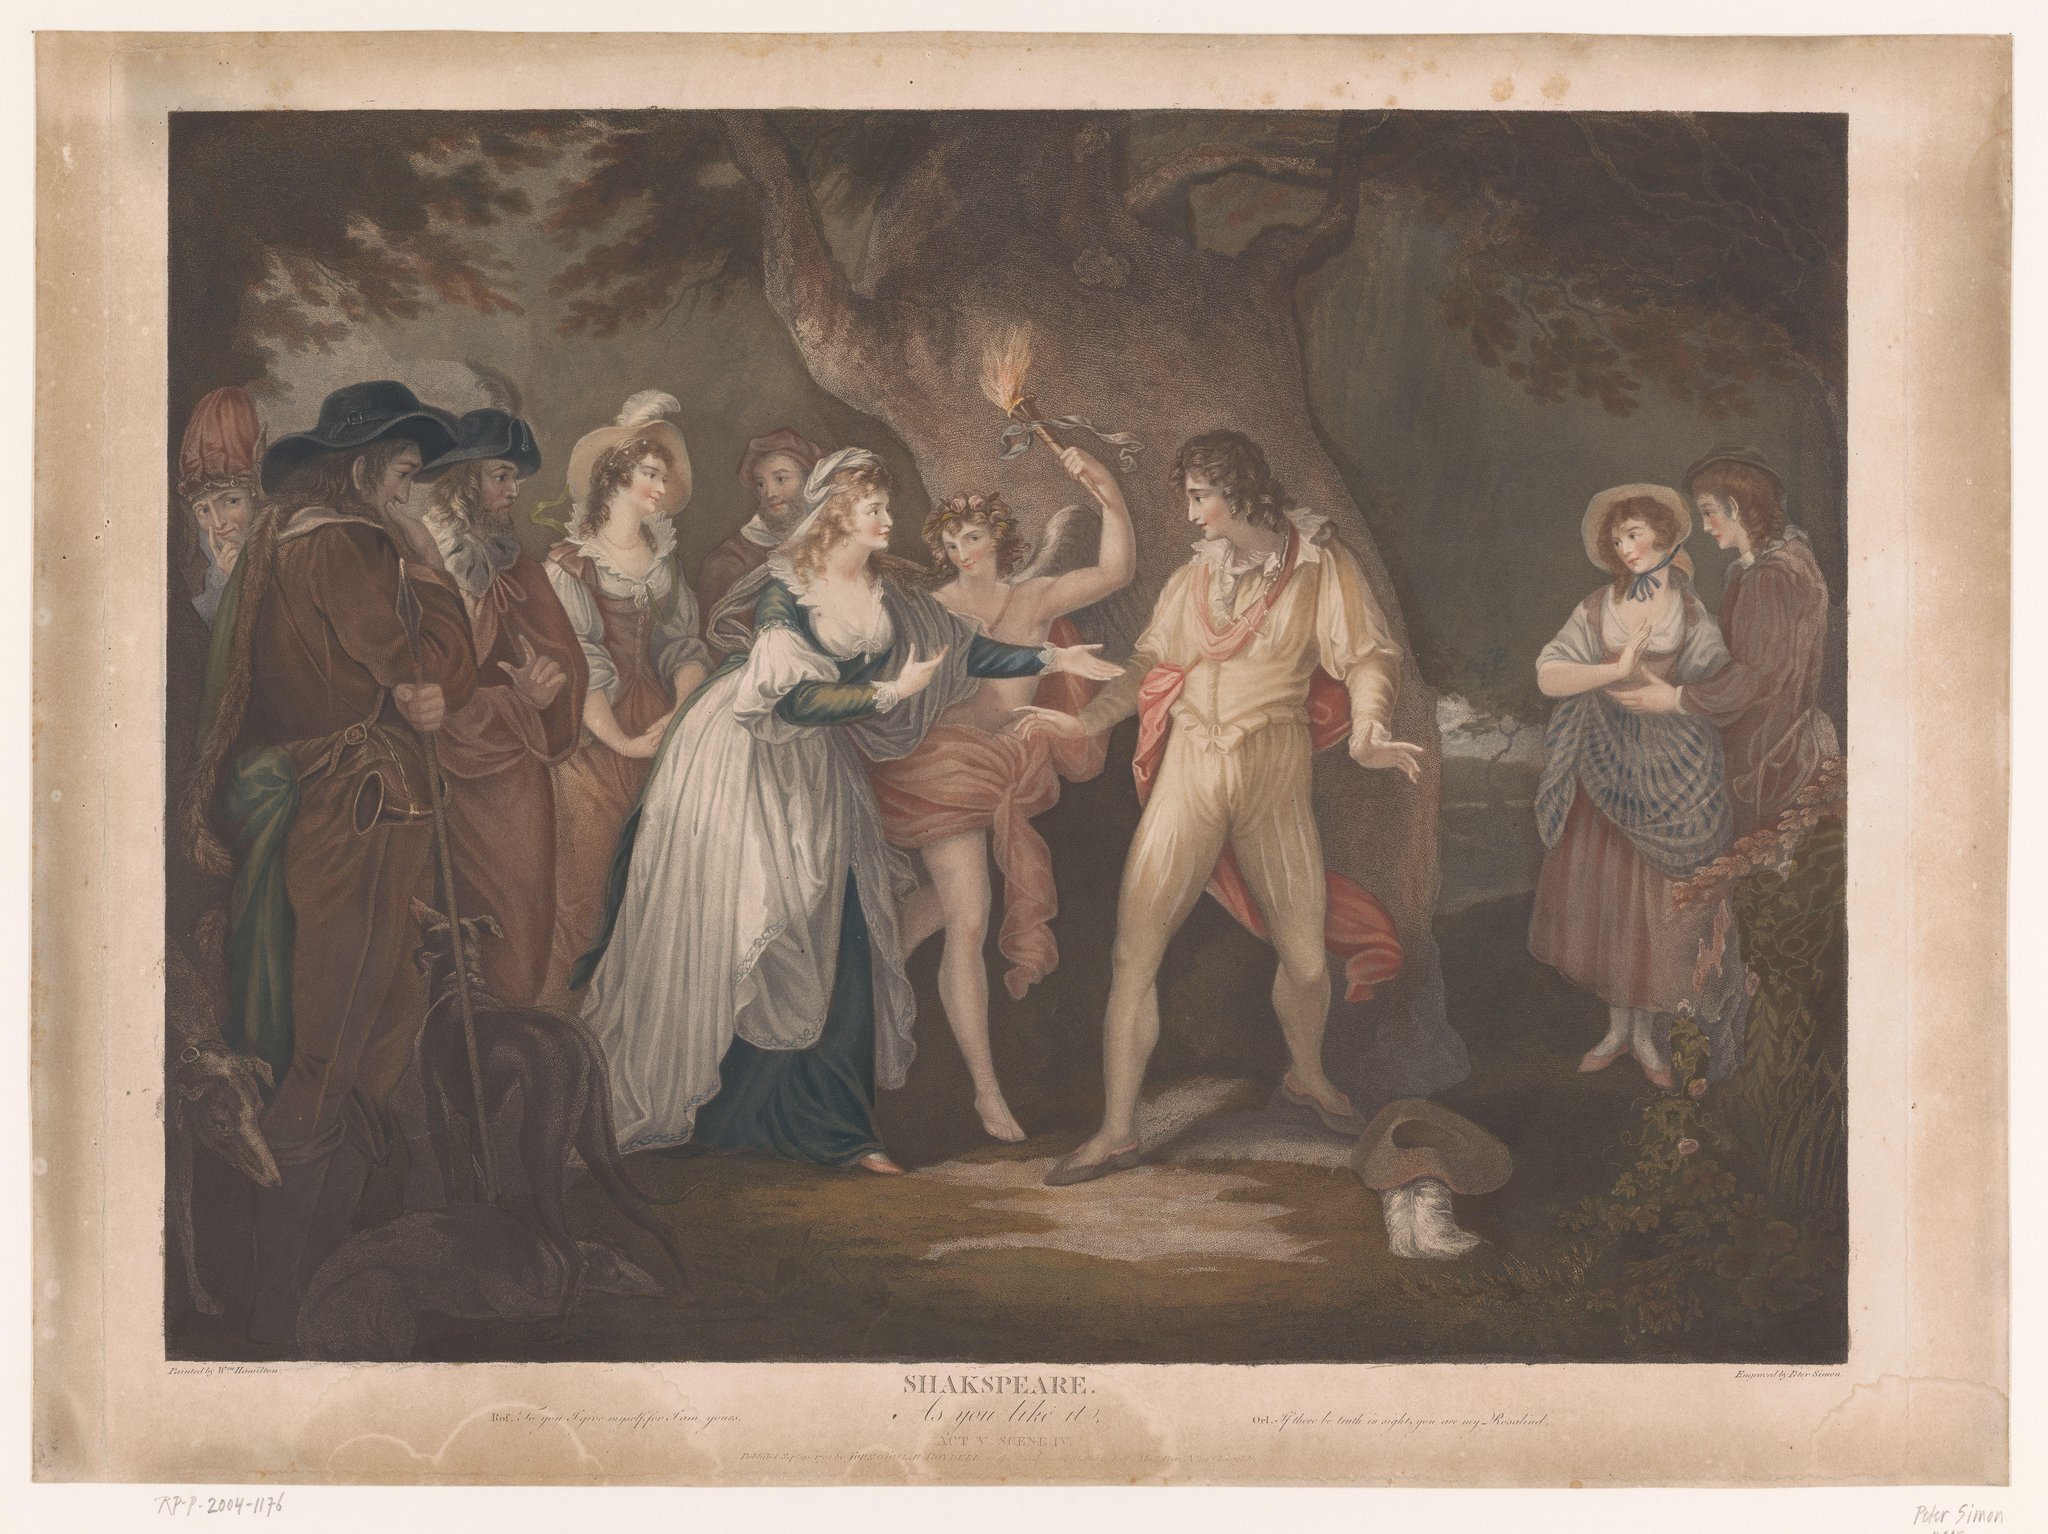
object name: print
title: Shakespeare. As you like it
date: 1791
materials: paper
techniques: aquatint, engraving, etching, hand coloring, lithography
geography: london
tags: (shakespeare, as you like it) specific works of literature (with author, title)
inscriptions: collector's mark: Lugt 2228, : ‘Ros. To you I give myself, for, I am yours./ Orl. If there be truth in sight, you are my Rosalind’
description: Akte 5, scène 4, uit het toneelstuk geschreven door William Shakespeare getiteld 'As You Like It'.